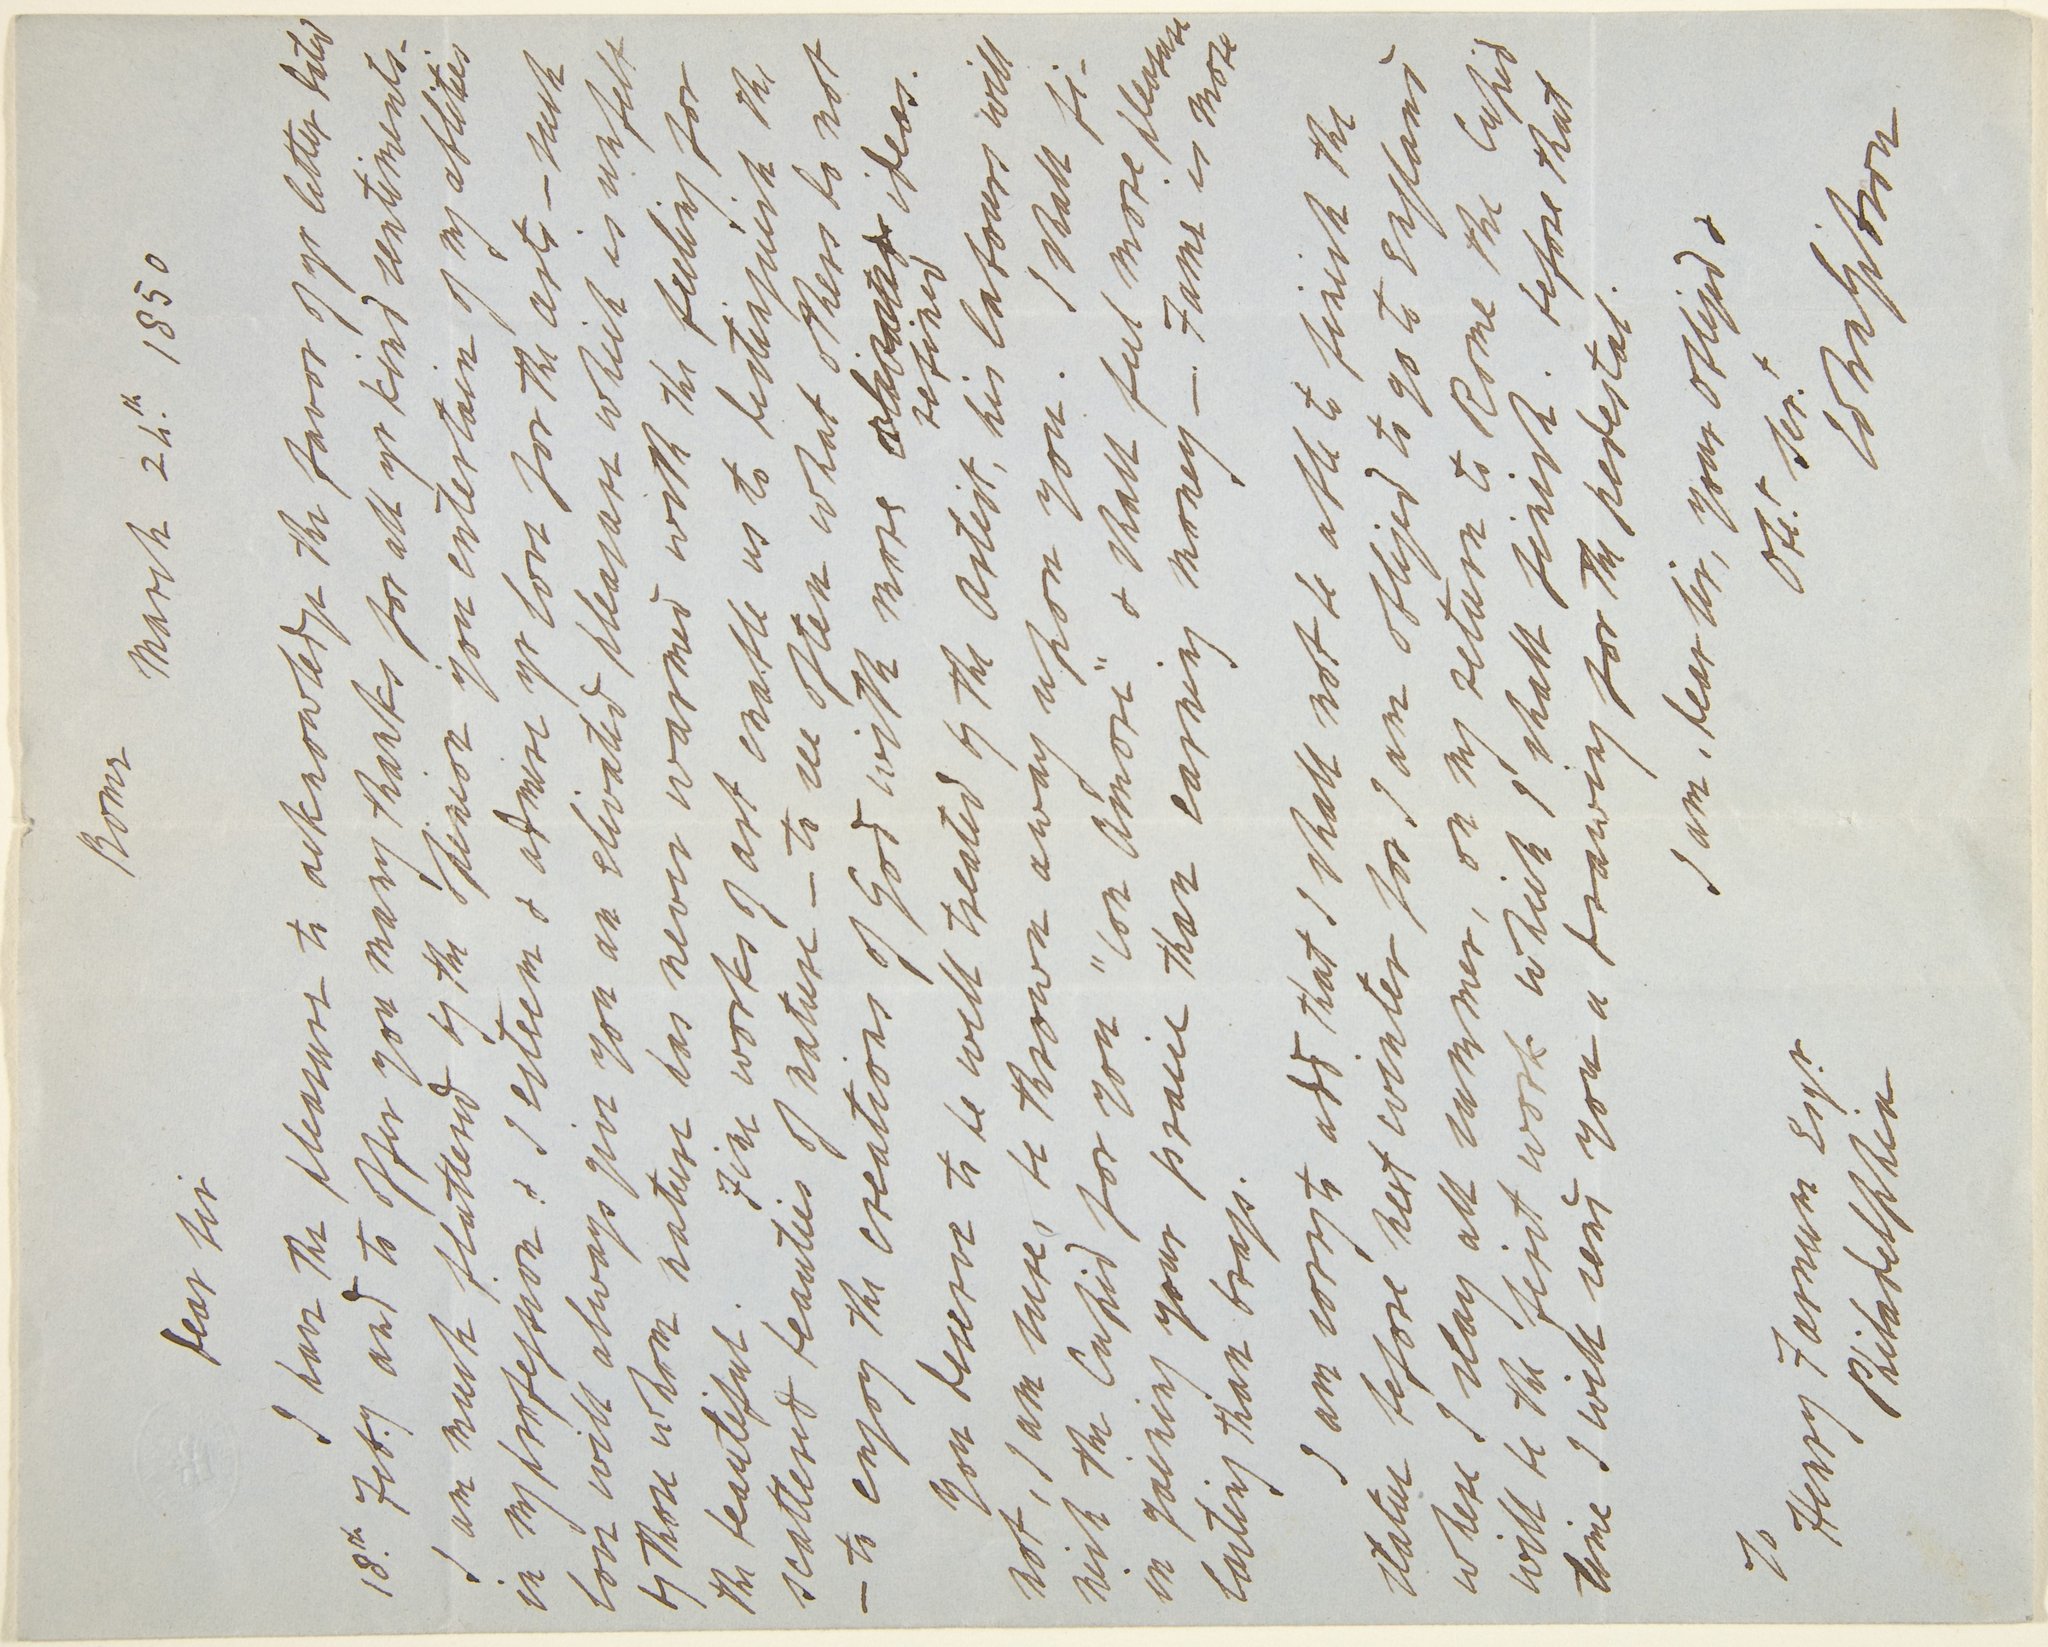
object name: letter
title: Letters to Henry Farnum from John Gibson and Benjamin Spence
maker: john gibson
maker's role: author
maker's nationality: british, born wales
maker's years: 1790-1866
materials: ink, paper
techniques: pen